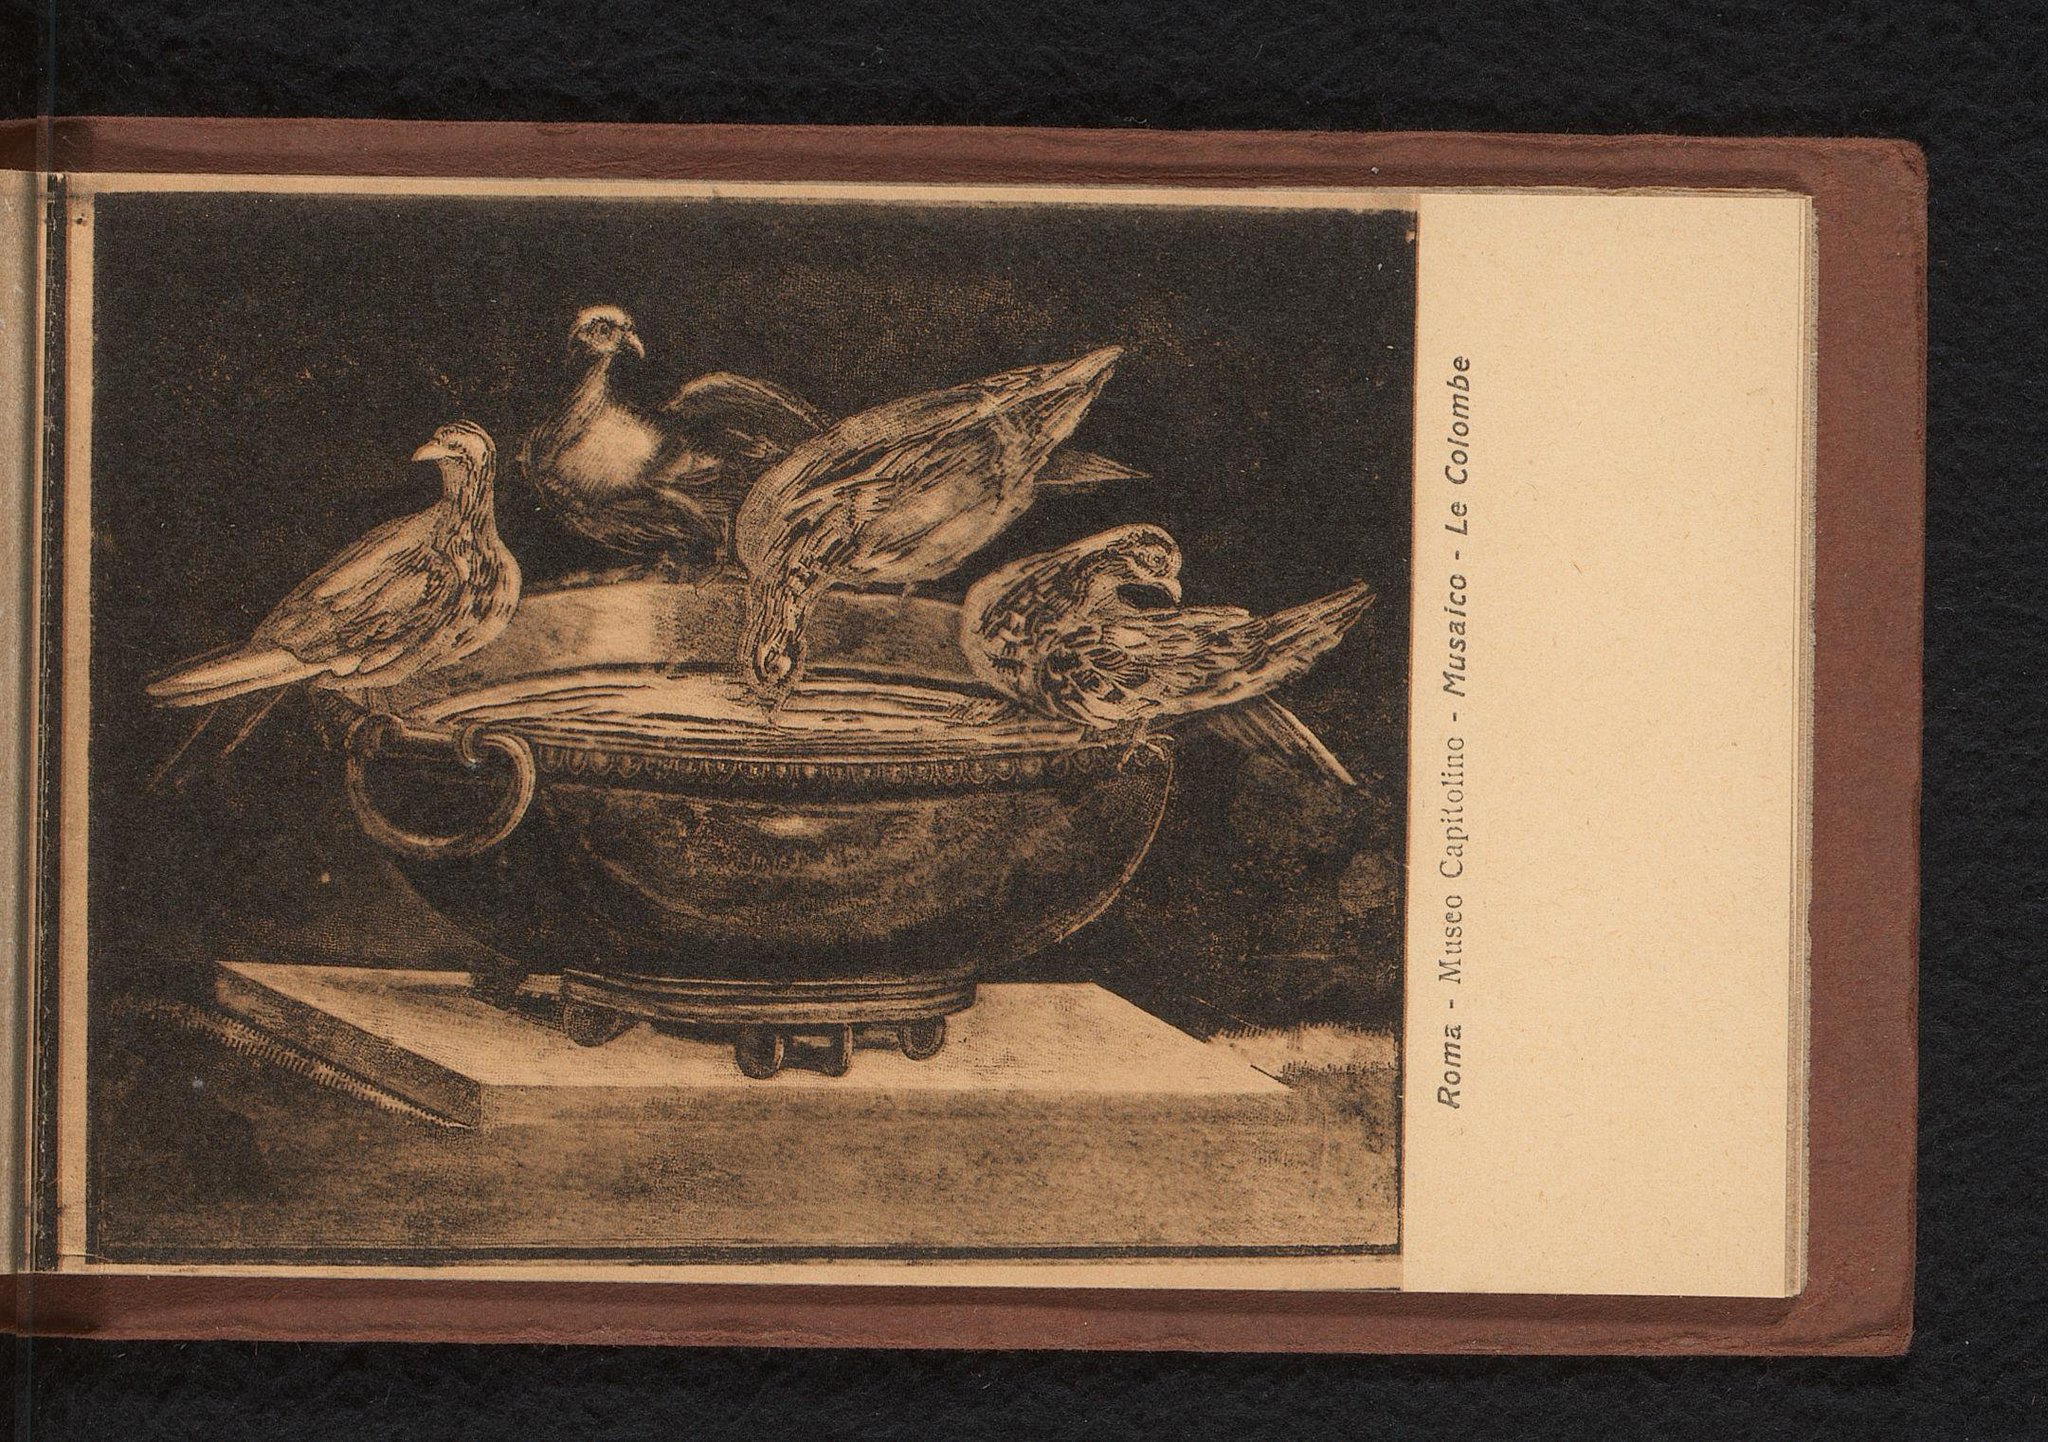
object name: photomechanical print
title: Roma - Museo Capitolino - Musaico - Le Colombe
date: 1905-1930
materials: cardboard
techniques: photograph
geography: rome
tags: permanent exhibition, museum, picture, painting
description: Prentbriefkaart maakt deel uit van een album.